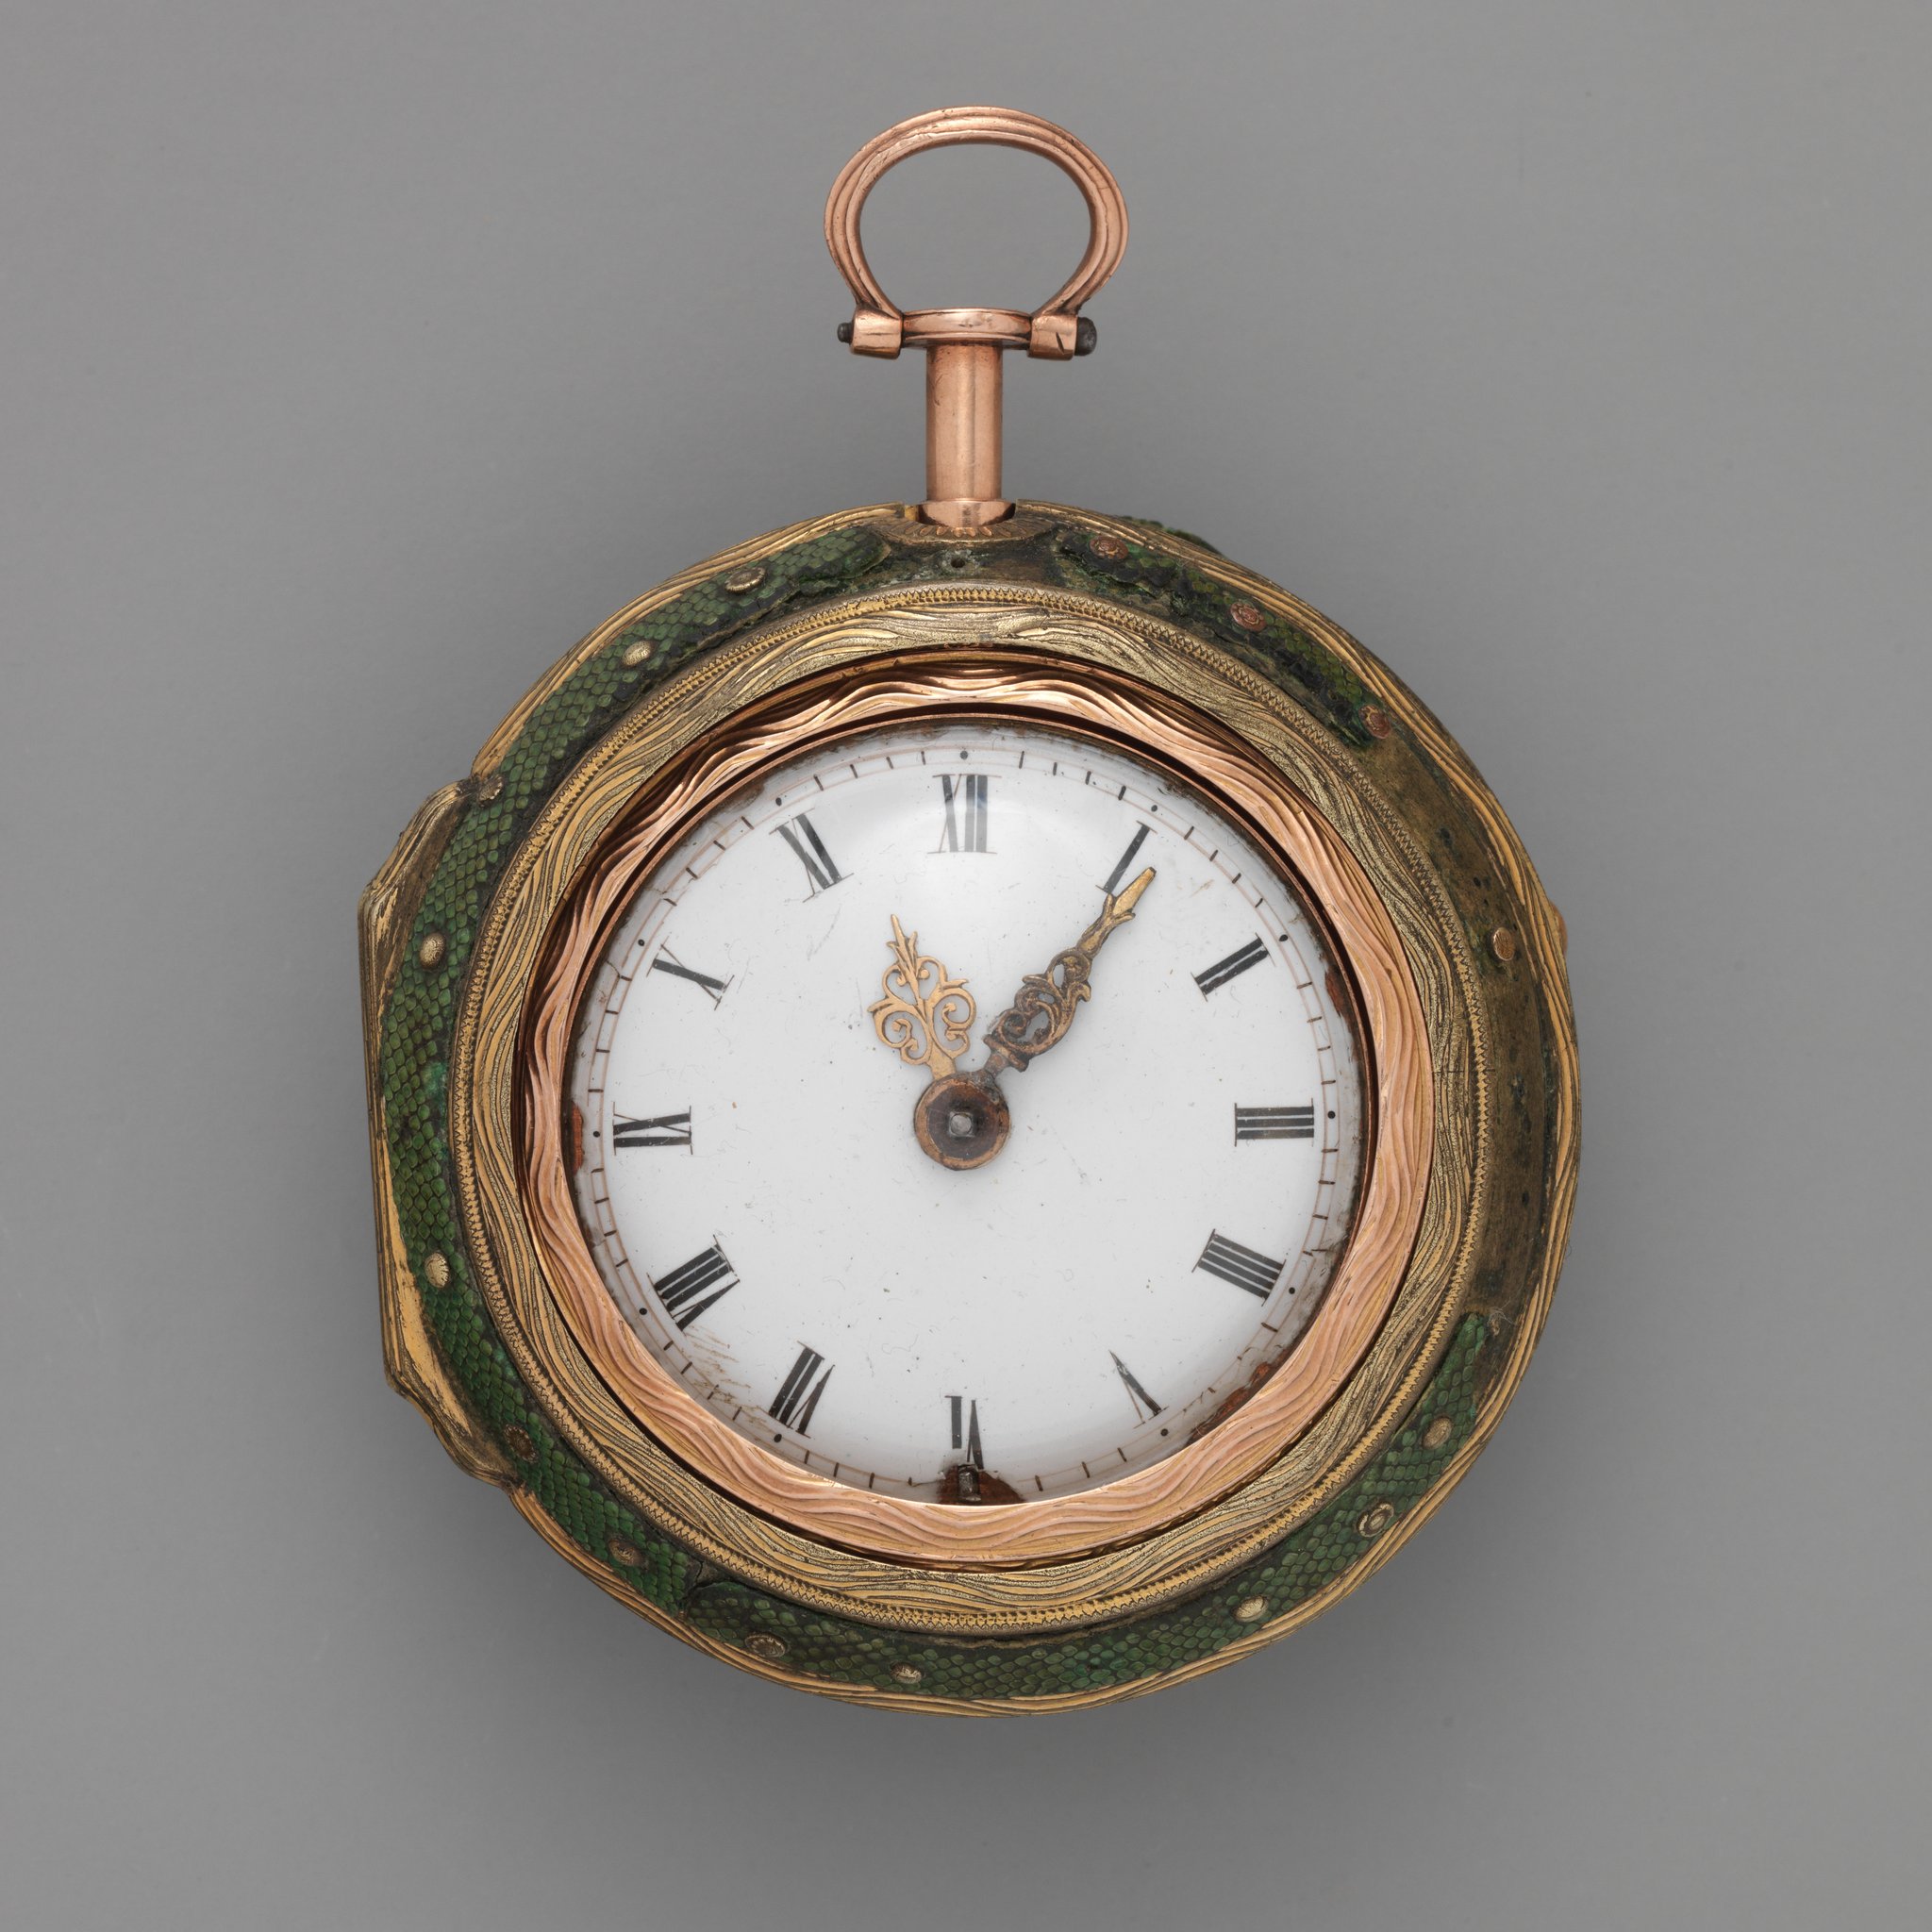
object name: watch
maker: (w.r.?) rose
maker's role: maker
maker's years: 1745-1755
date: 1701-1800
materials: gilt copper, enamel, silver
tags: human figures,musical instruments